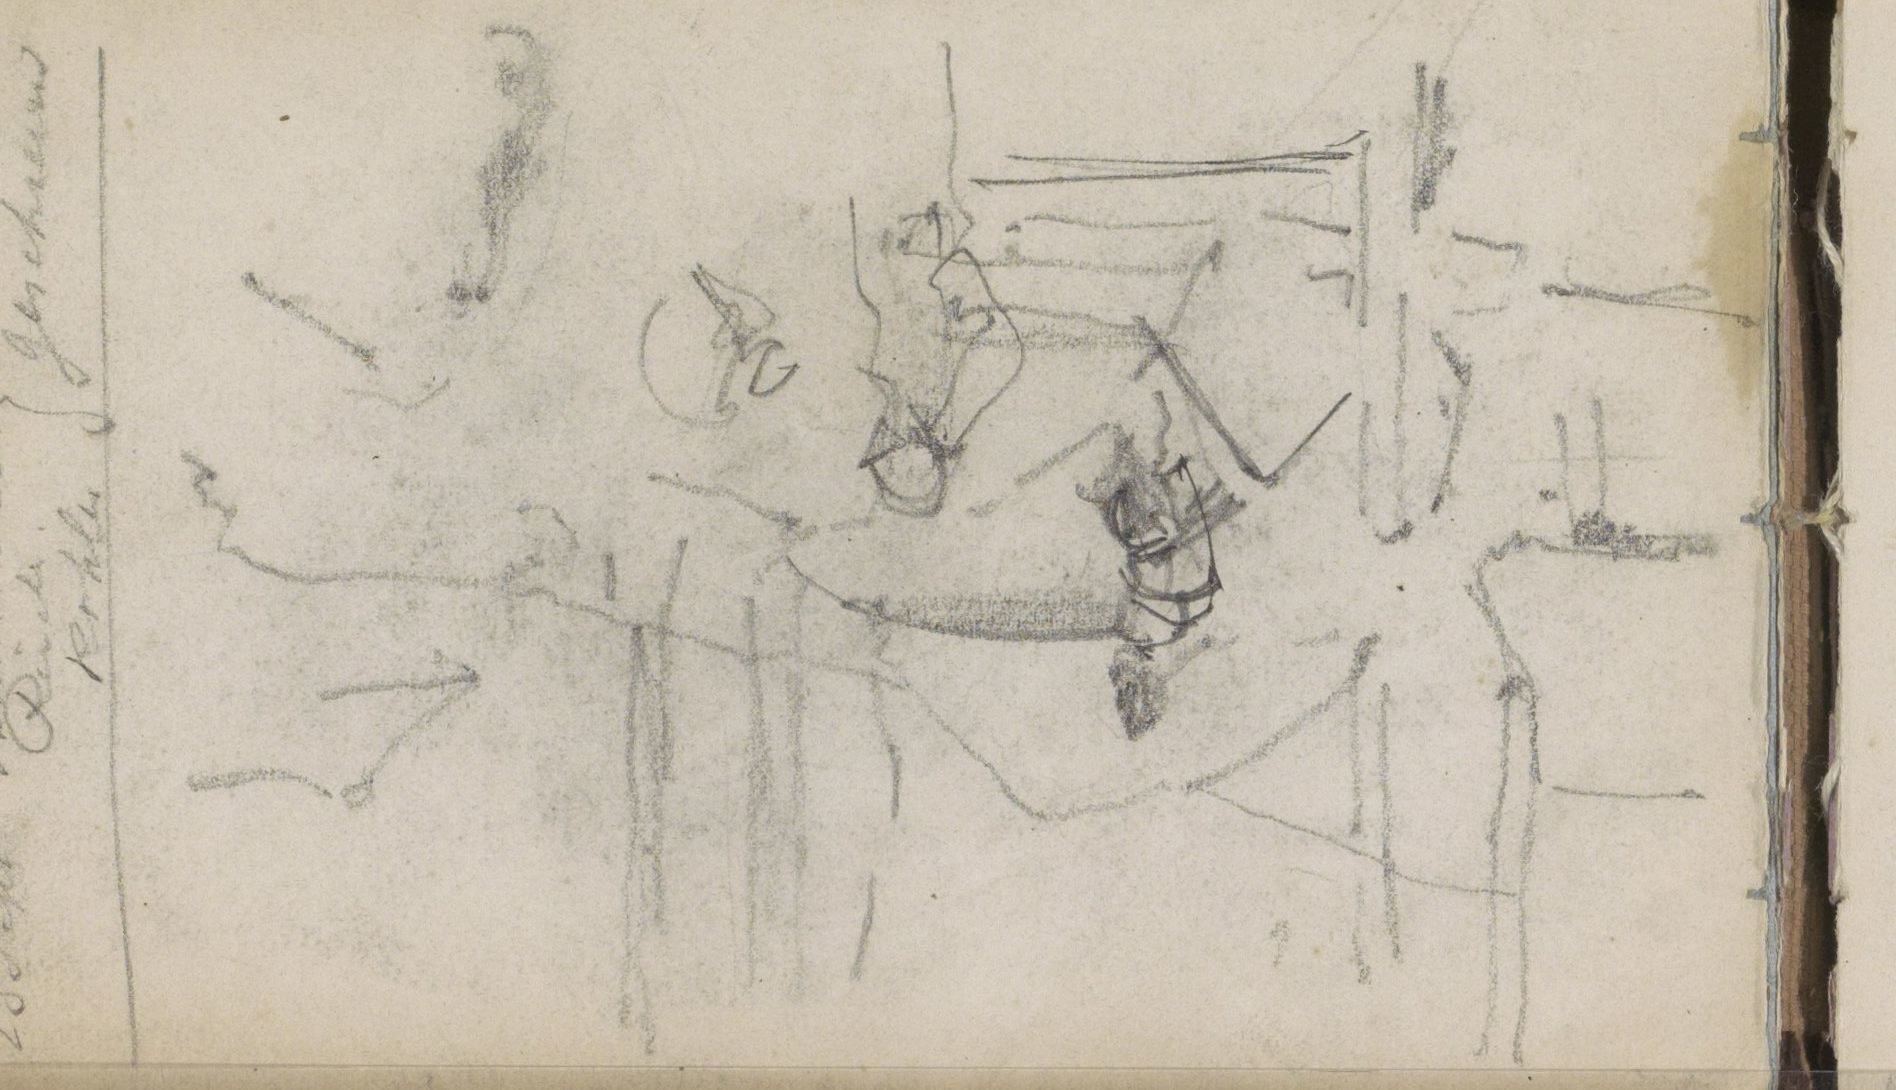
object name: sketchbook leaf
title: Figuur en dier in een landschap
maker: george hendrik breitner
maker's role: draughtsman, painter, print maker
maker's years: 1857-1923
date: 1881-1883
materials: paper, pencil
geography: north brabant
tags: landscapes, animals, the soldier; the soldier's life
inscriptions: annotation: ‘28 sept Van de Weele/ Reicher/ Köhler/ geschreven’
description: Mogelijk een soldaat. Erachter een dier. Pagina 3 uit een schetsboek met 42 bladen.